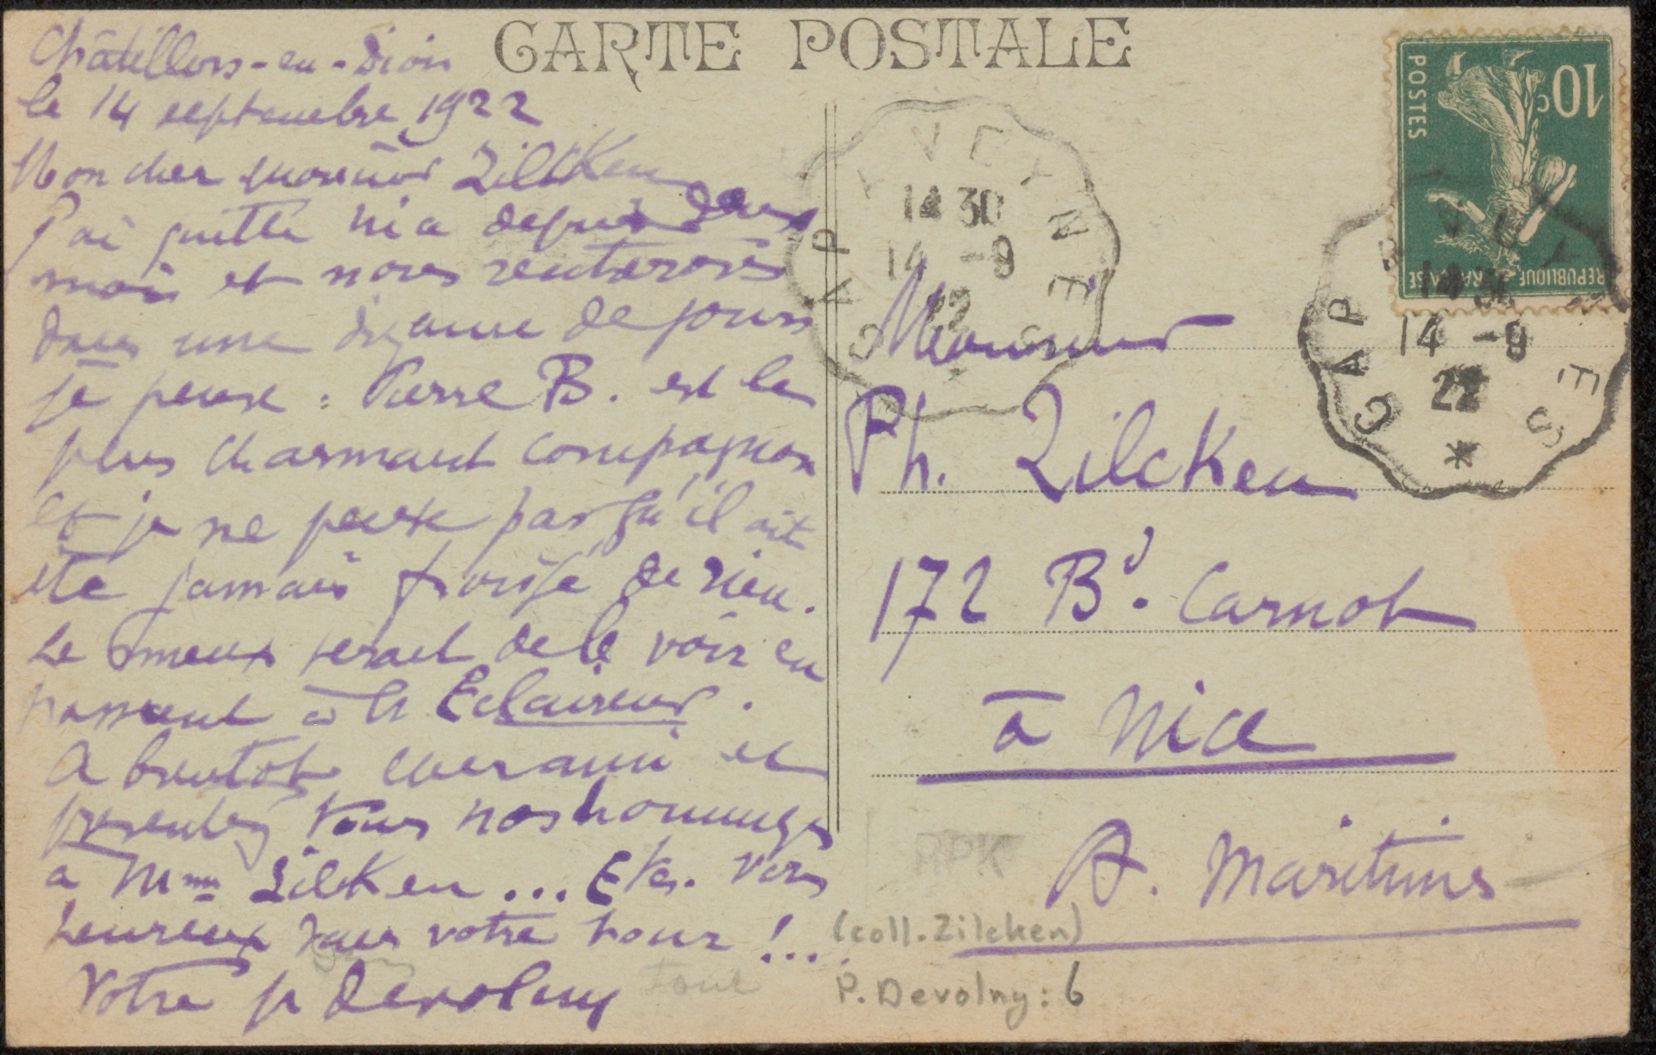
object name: ansichtkaart, prentbriefkaart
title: Prentbriefkaart aan Philip Zilcken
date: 1922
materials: cardboard, ink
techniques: photograph, pen, writing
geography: châtillon-en-diois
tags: the hague, painter, draughtsman, philip zilcken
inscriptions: collector's mark: ‘RPK’